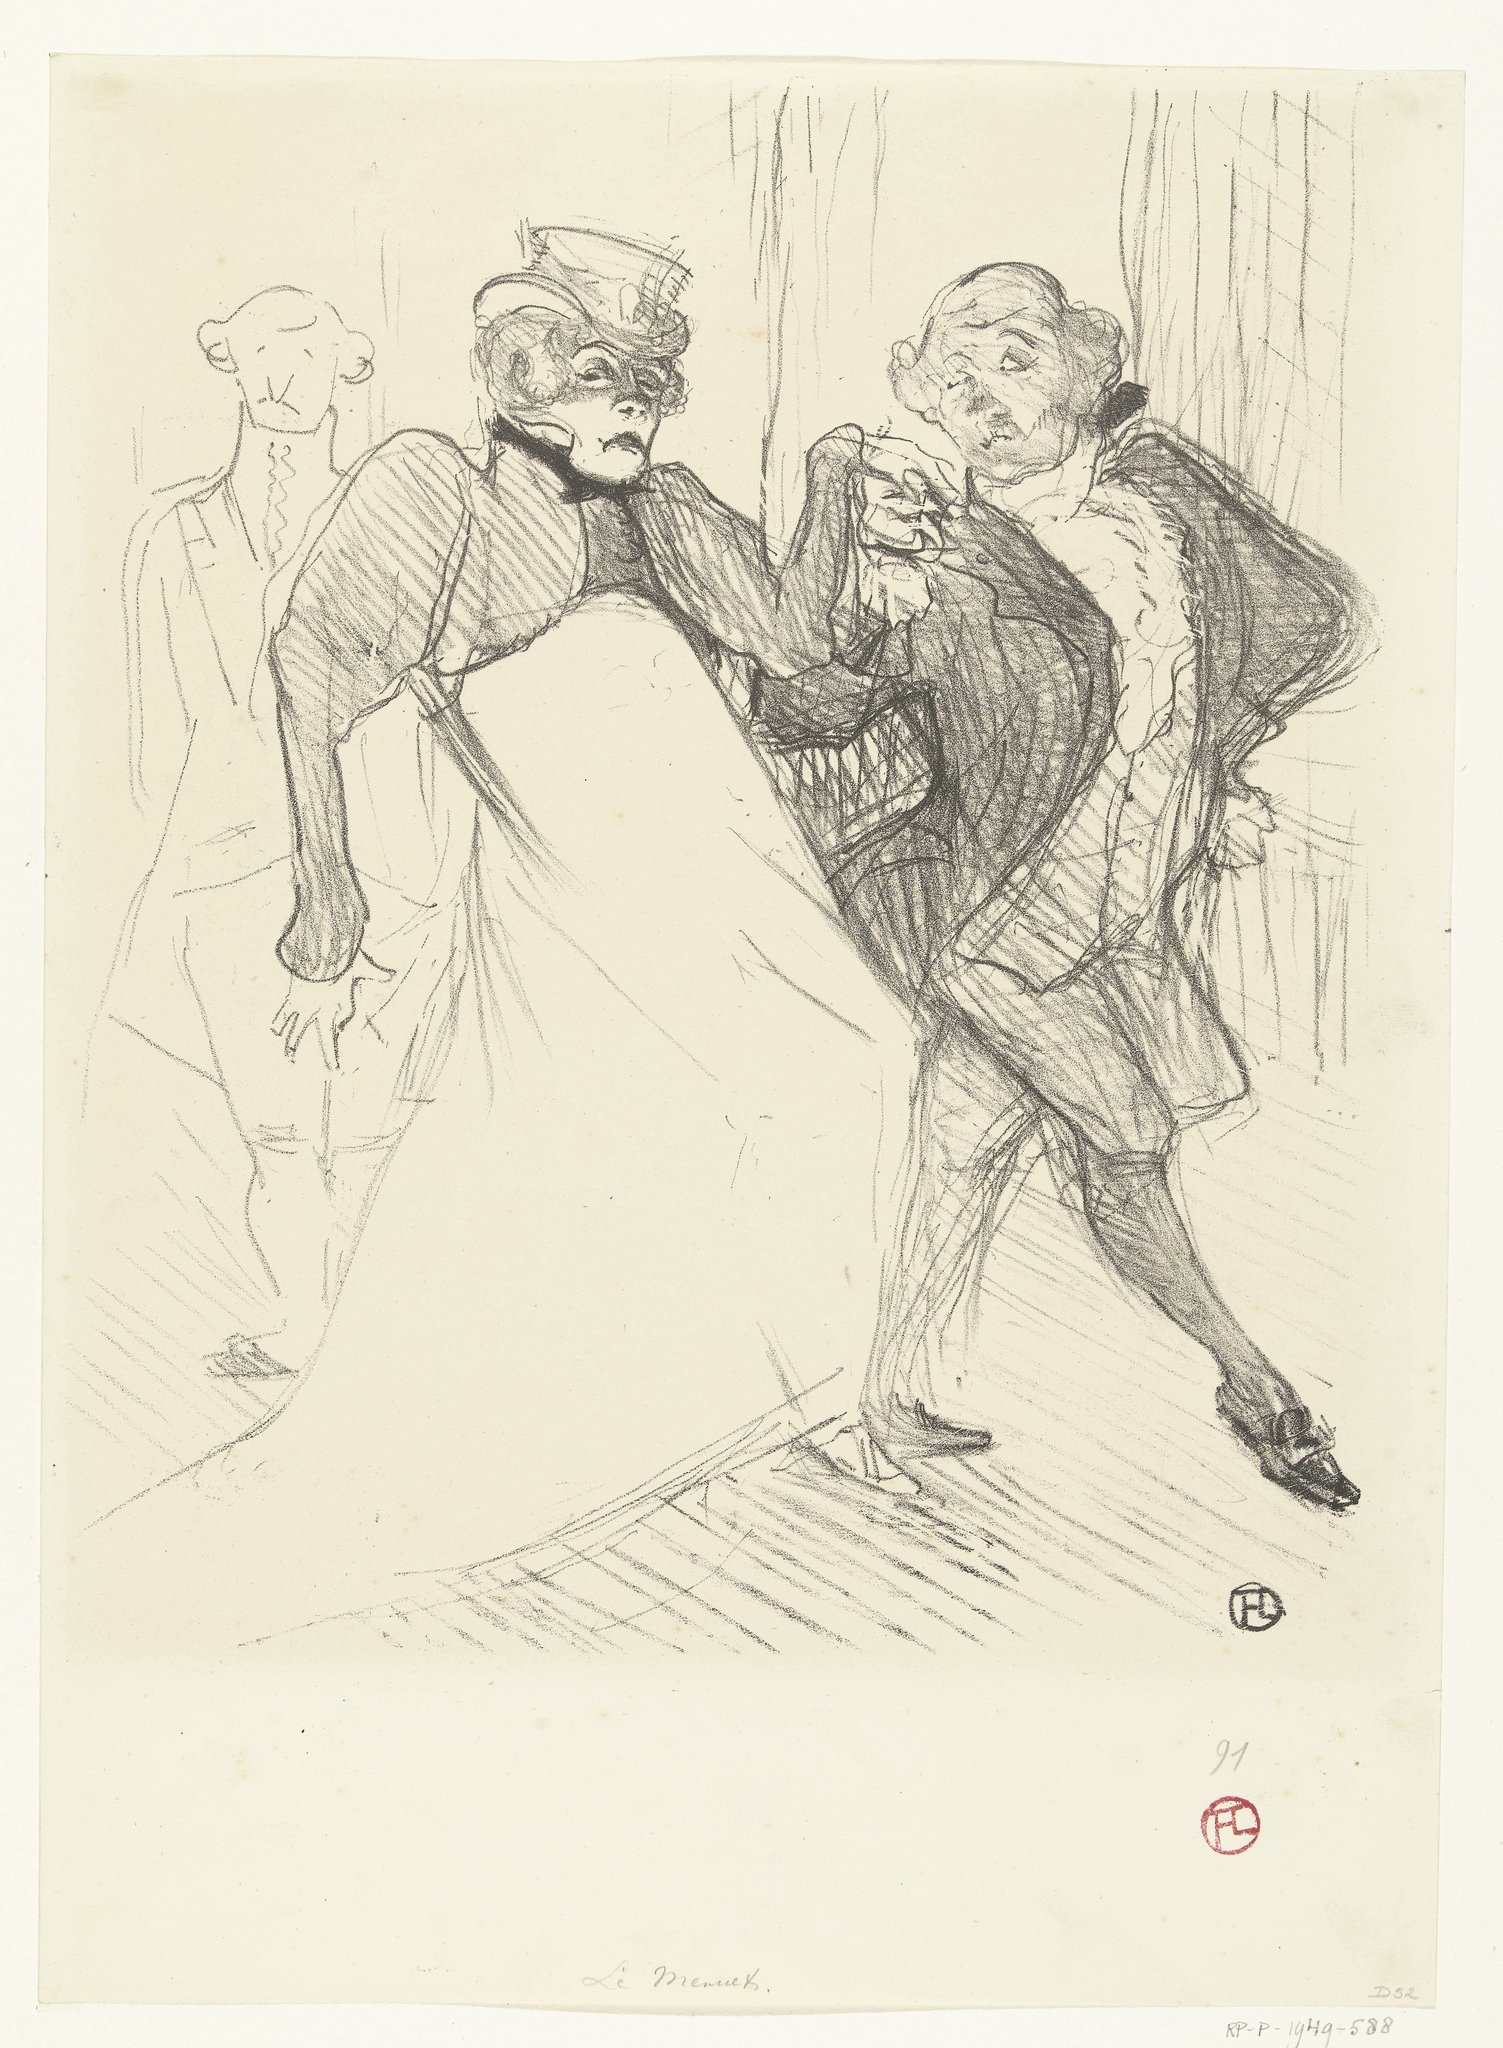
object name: print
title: Rejave et Galipaux, dans Madame Sans Gène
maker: henri de toulouse-lautrec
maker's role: draughtsman, painter, print maker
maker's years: 1864-1901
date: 1893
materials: paper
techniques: lithograph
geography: paris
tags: paris, actor (on the stage)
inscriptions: collector's mark: Lugt 2228, collector's mark: Lugt 2760, stamp: Lugt 1338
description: Actrice Gabrielle Rejane krijgt in haar rol als schoonmoeder dansles van actuer Felix Galipaux in het toneelstuk Madame Sans-Gêne.